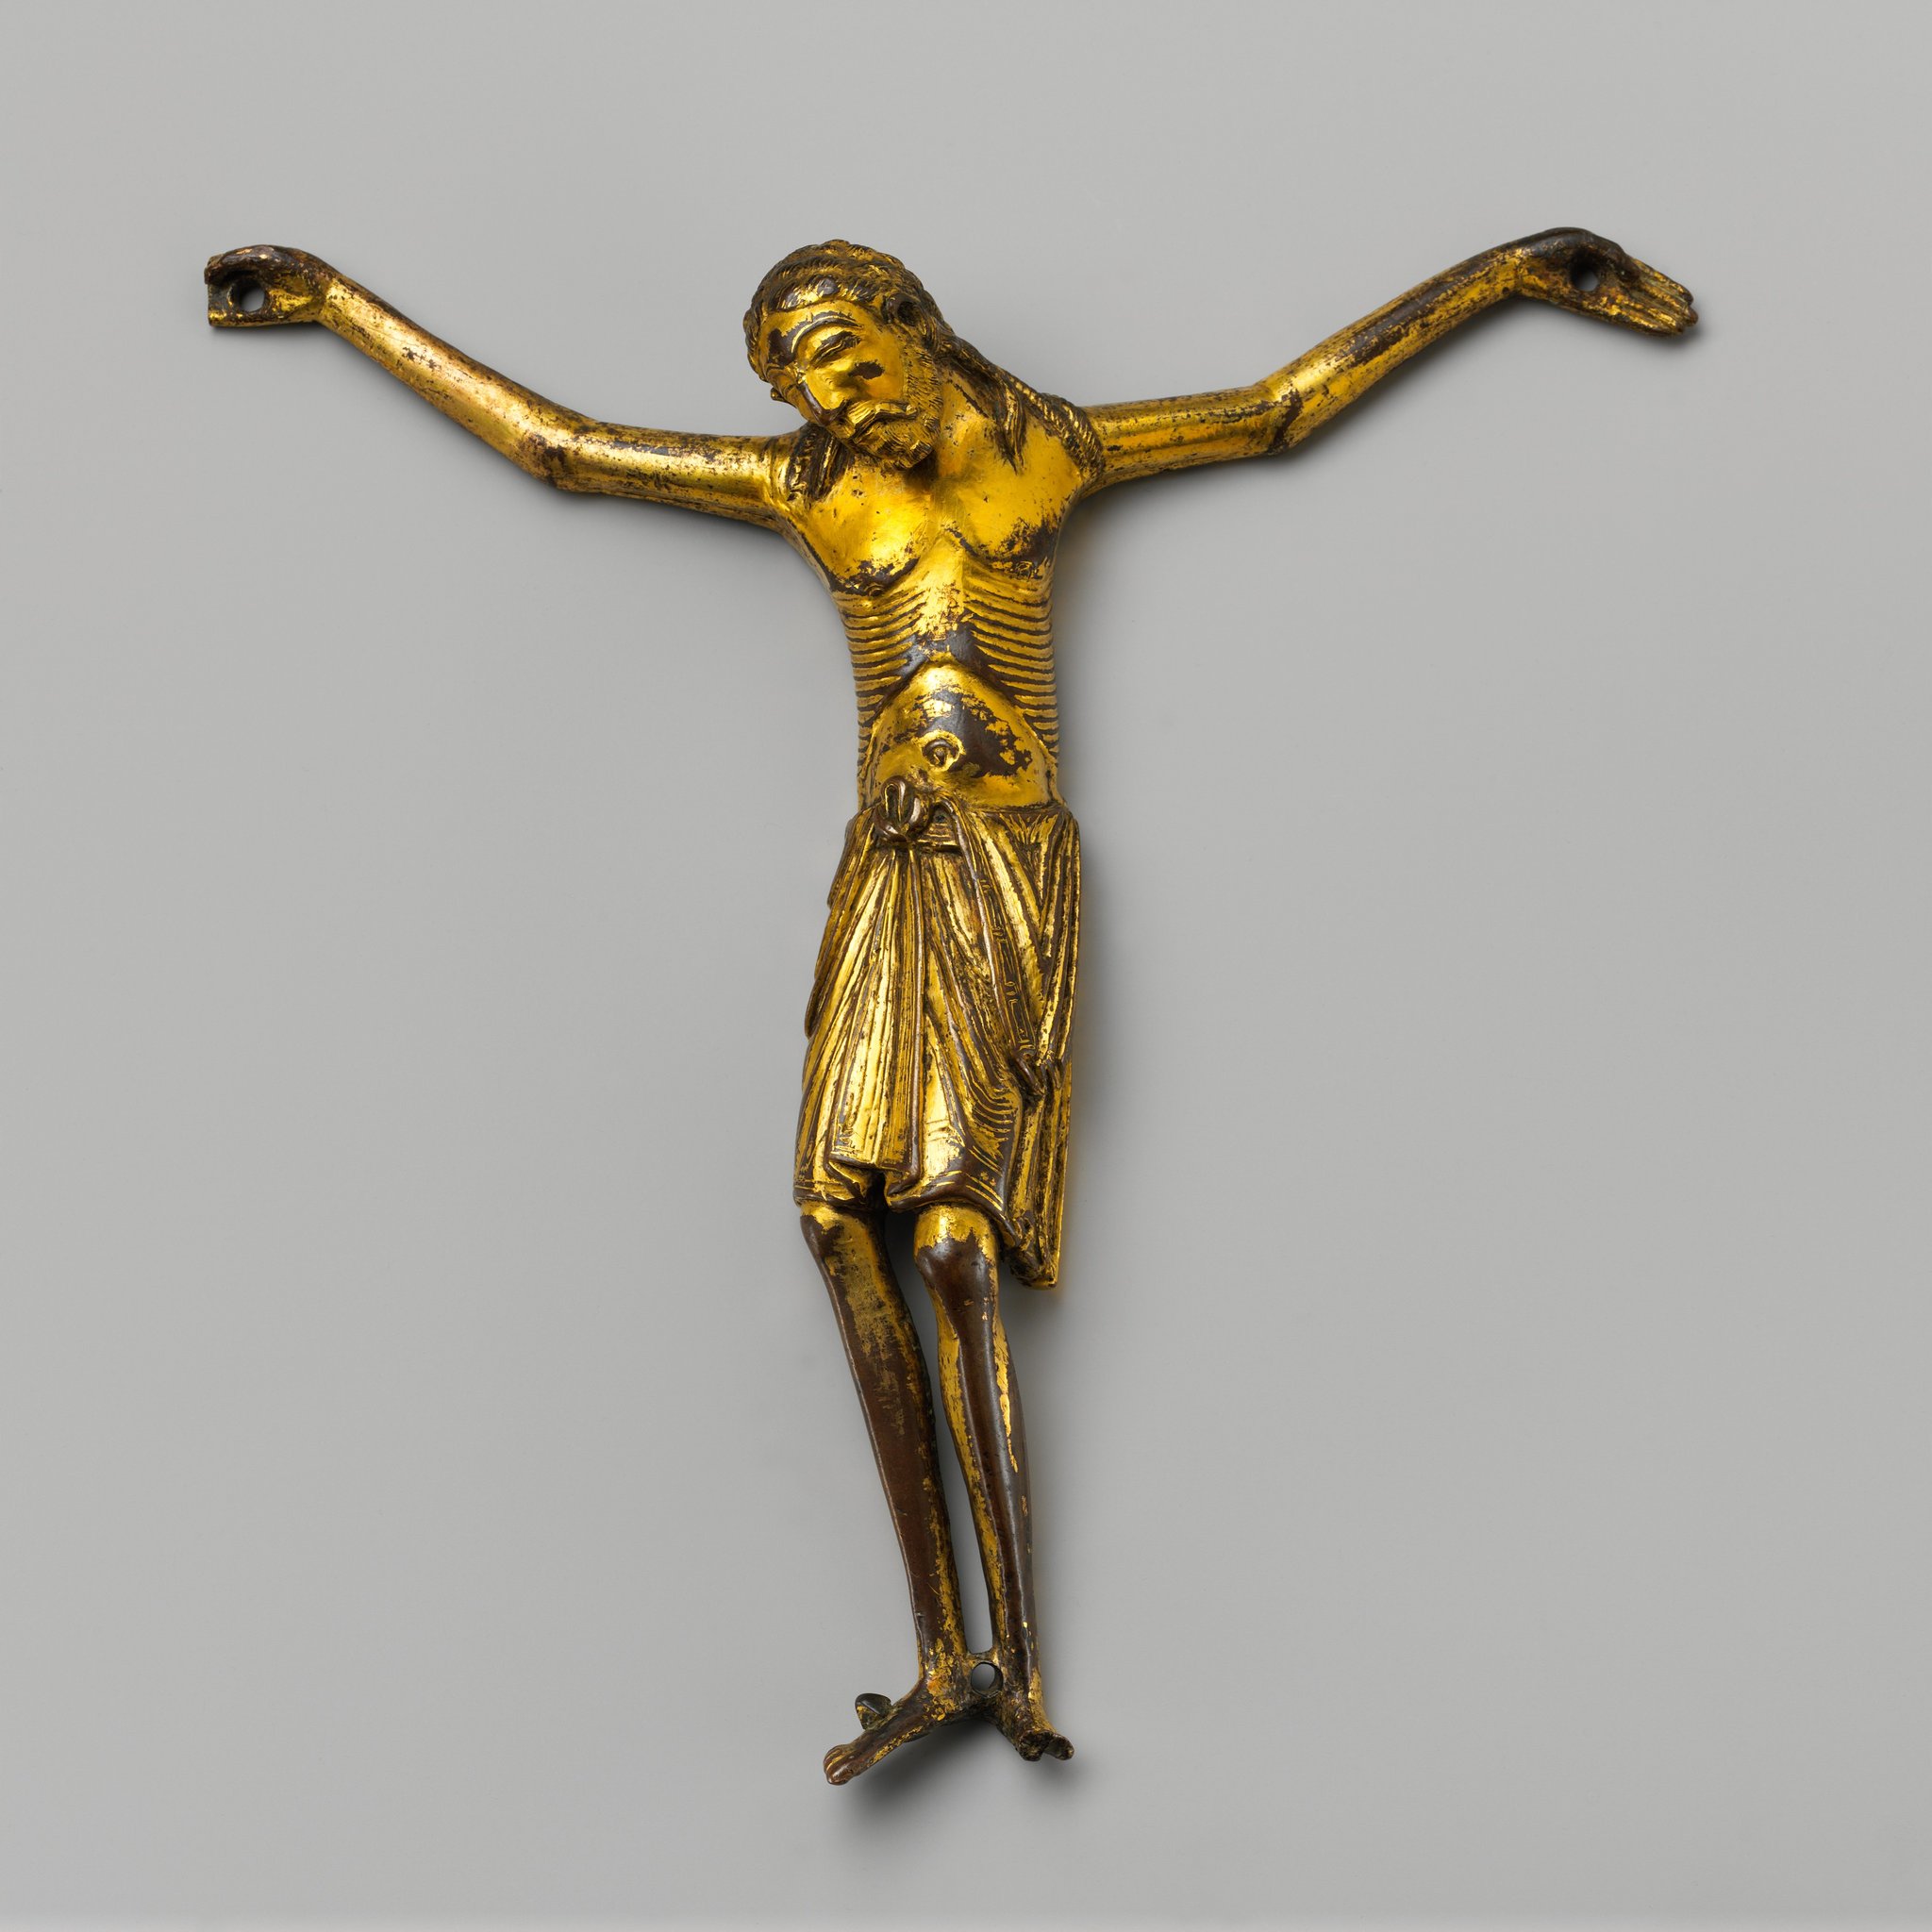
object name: corpus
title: Crucified Christ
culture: french or british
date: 1125-1150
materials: copper alloy, gilt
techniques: casting